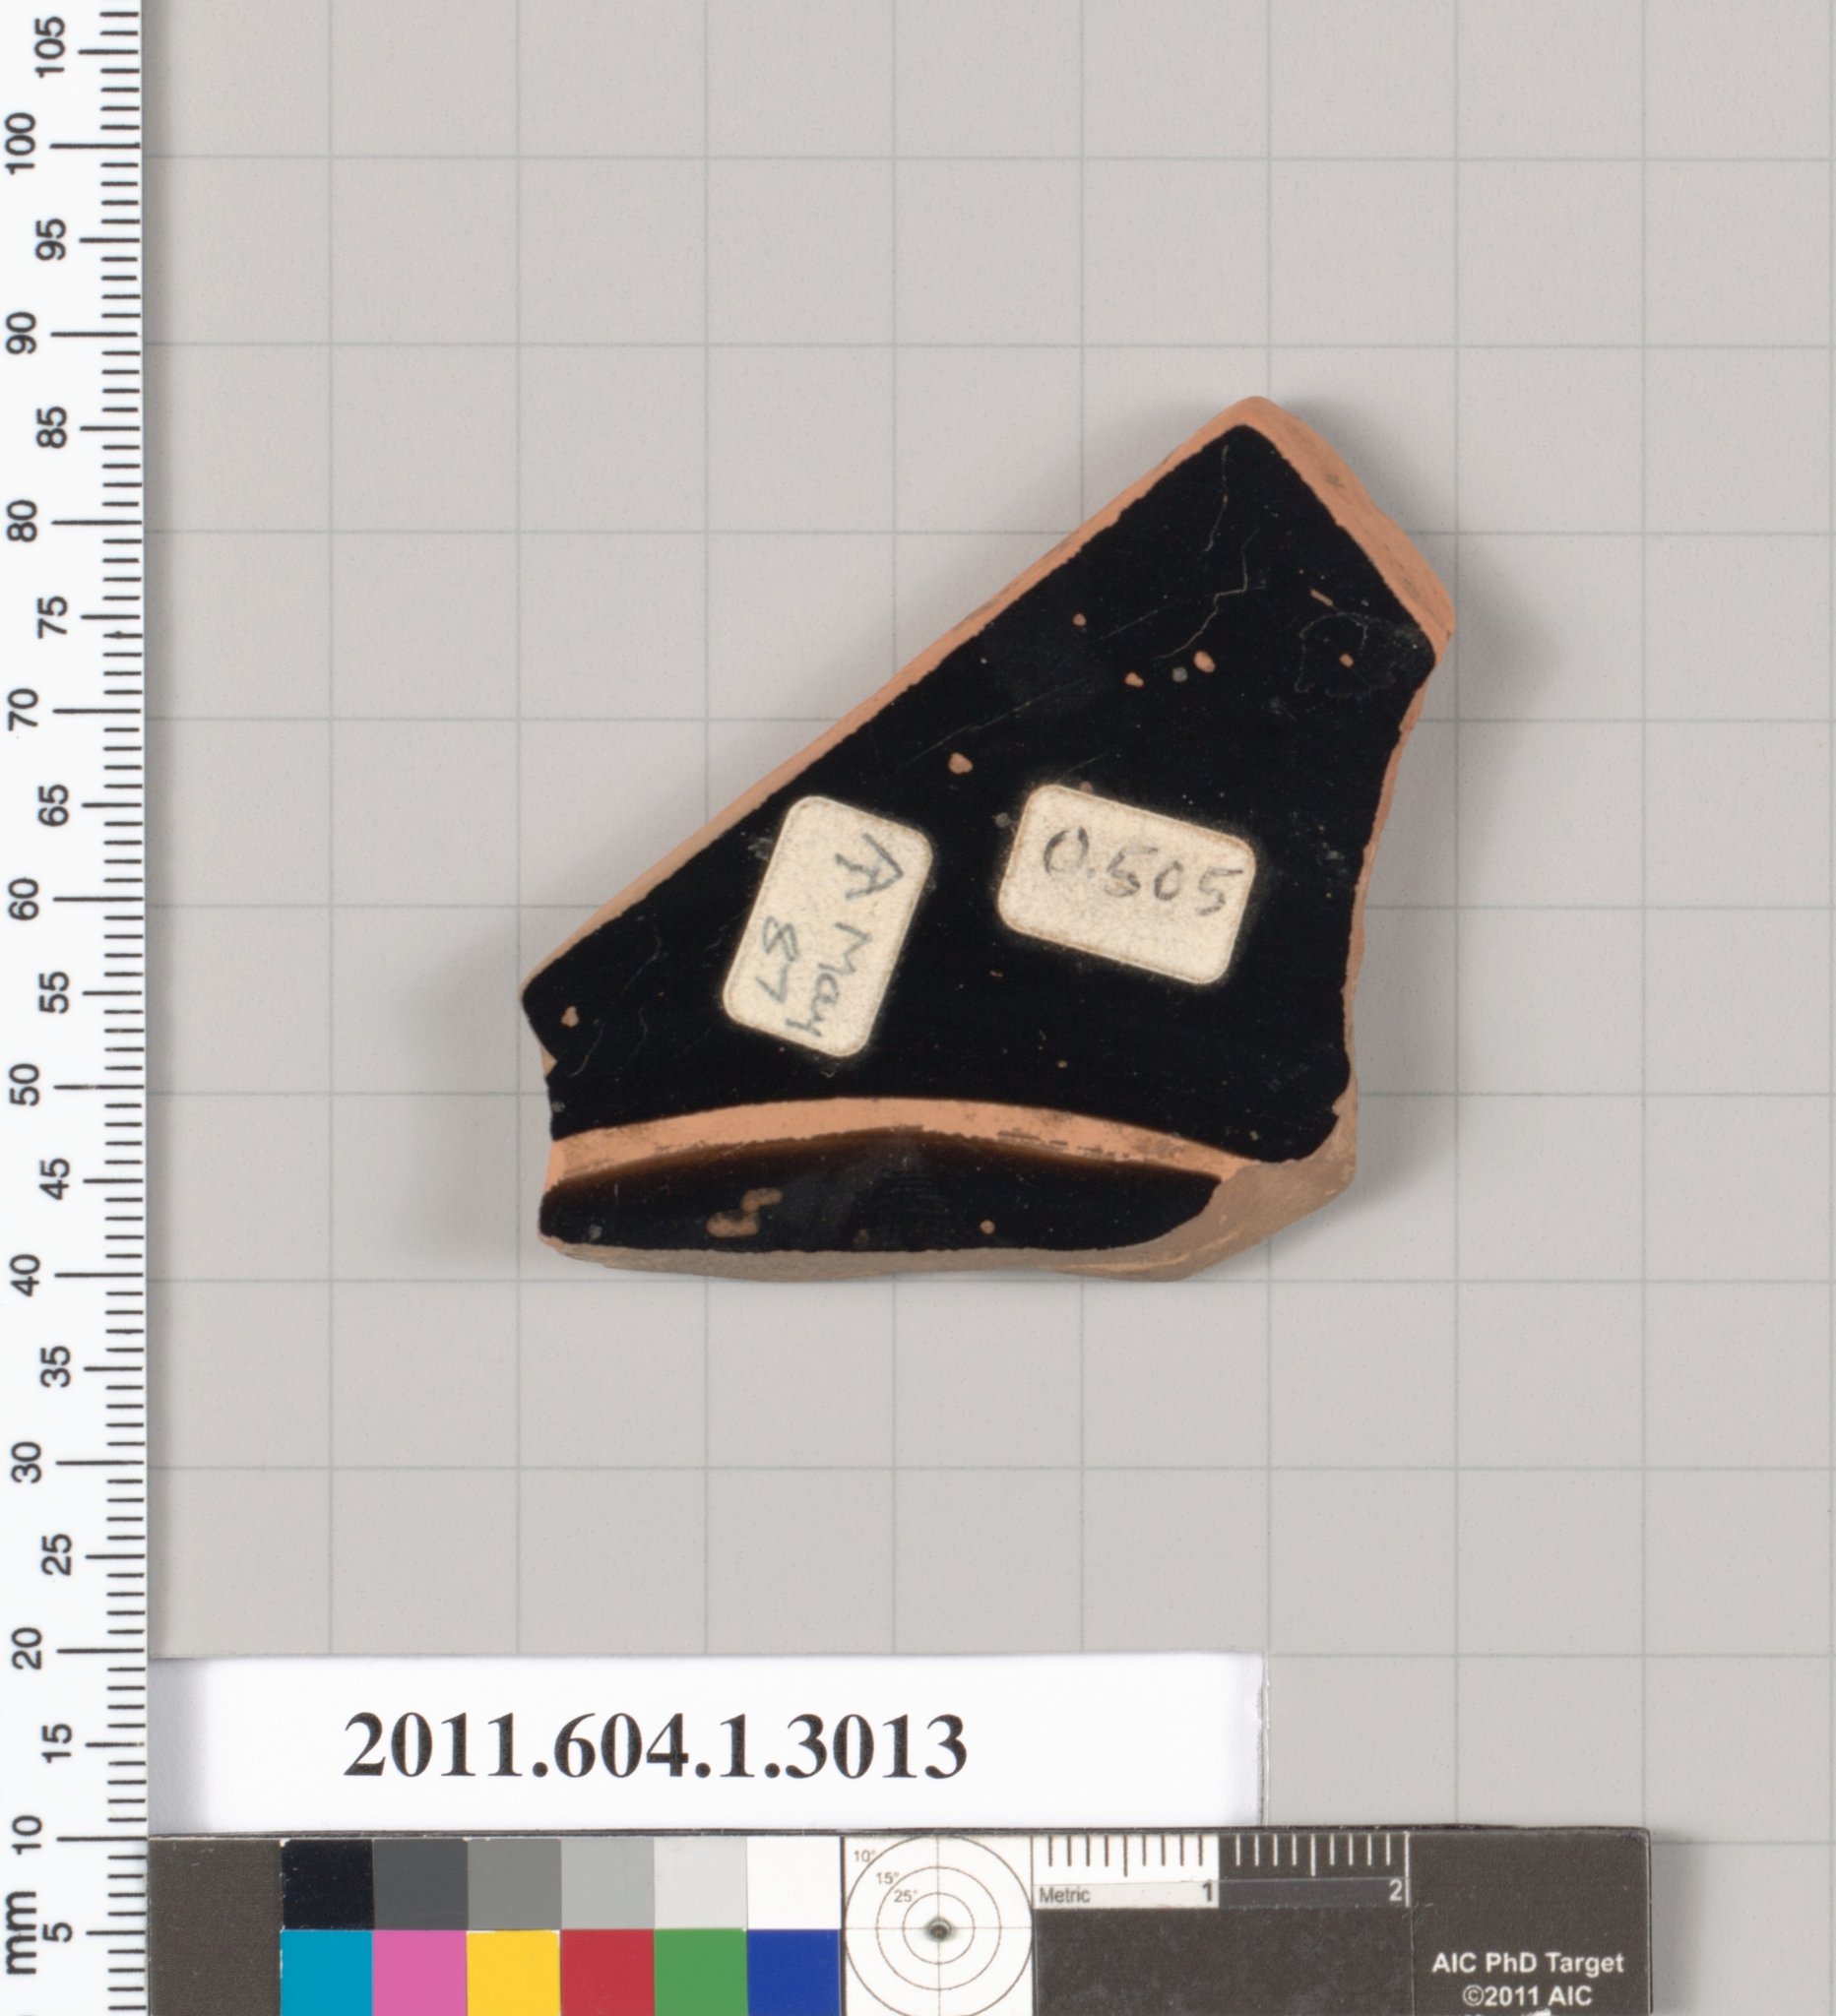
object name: kylix fragment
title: Terracotta fragment of a kylix (drinking cup)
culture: greek, attic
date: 520-500 BCE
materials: terracotta